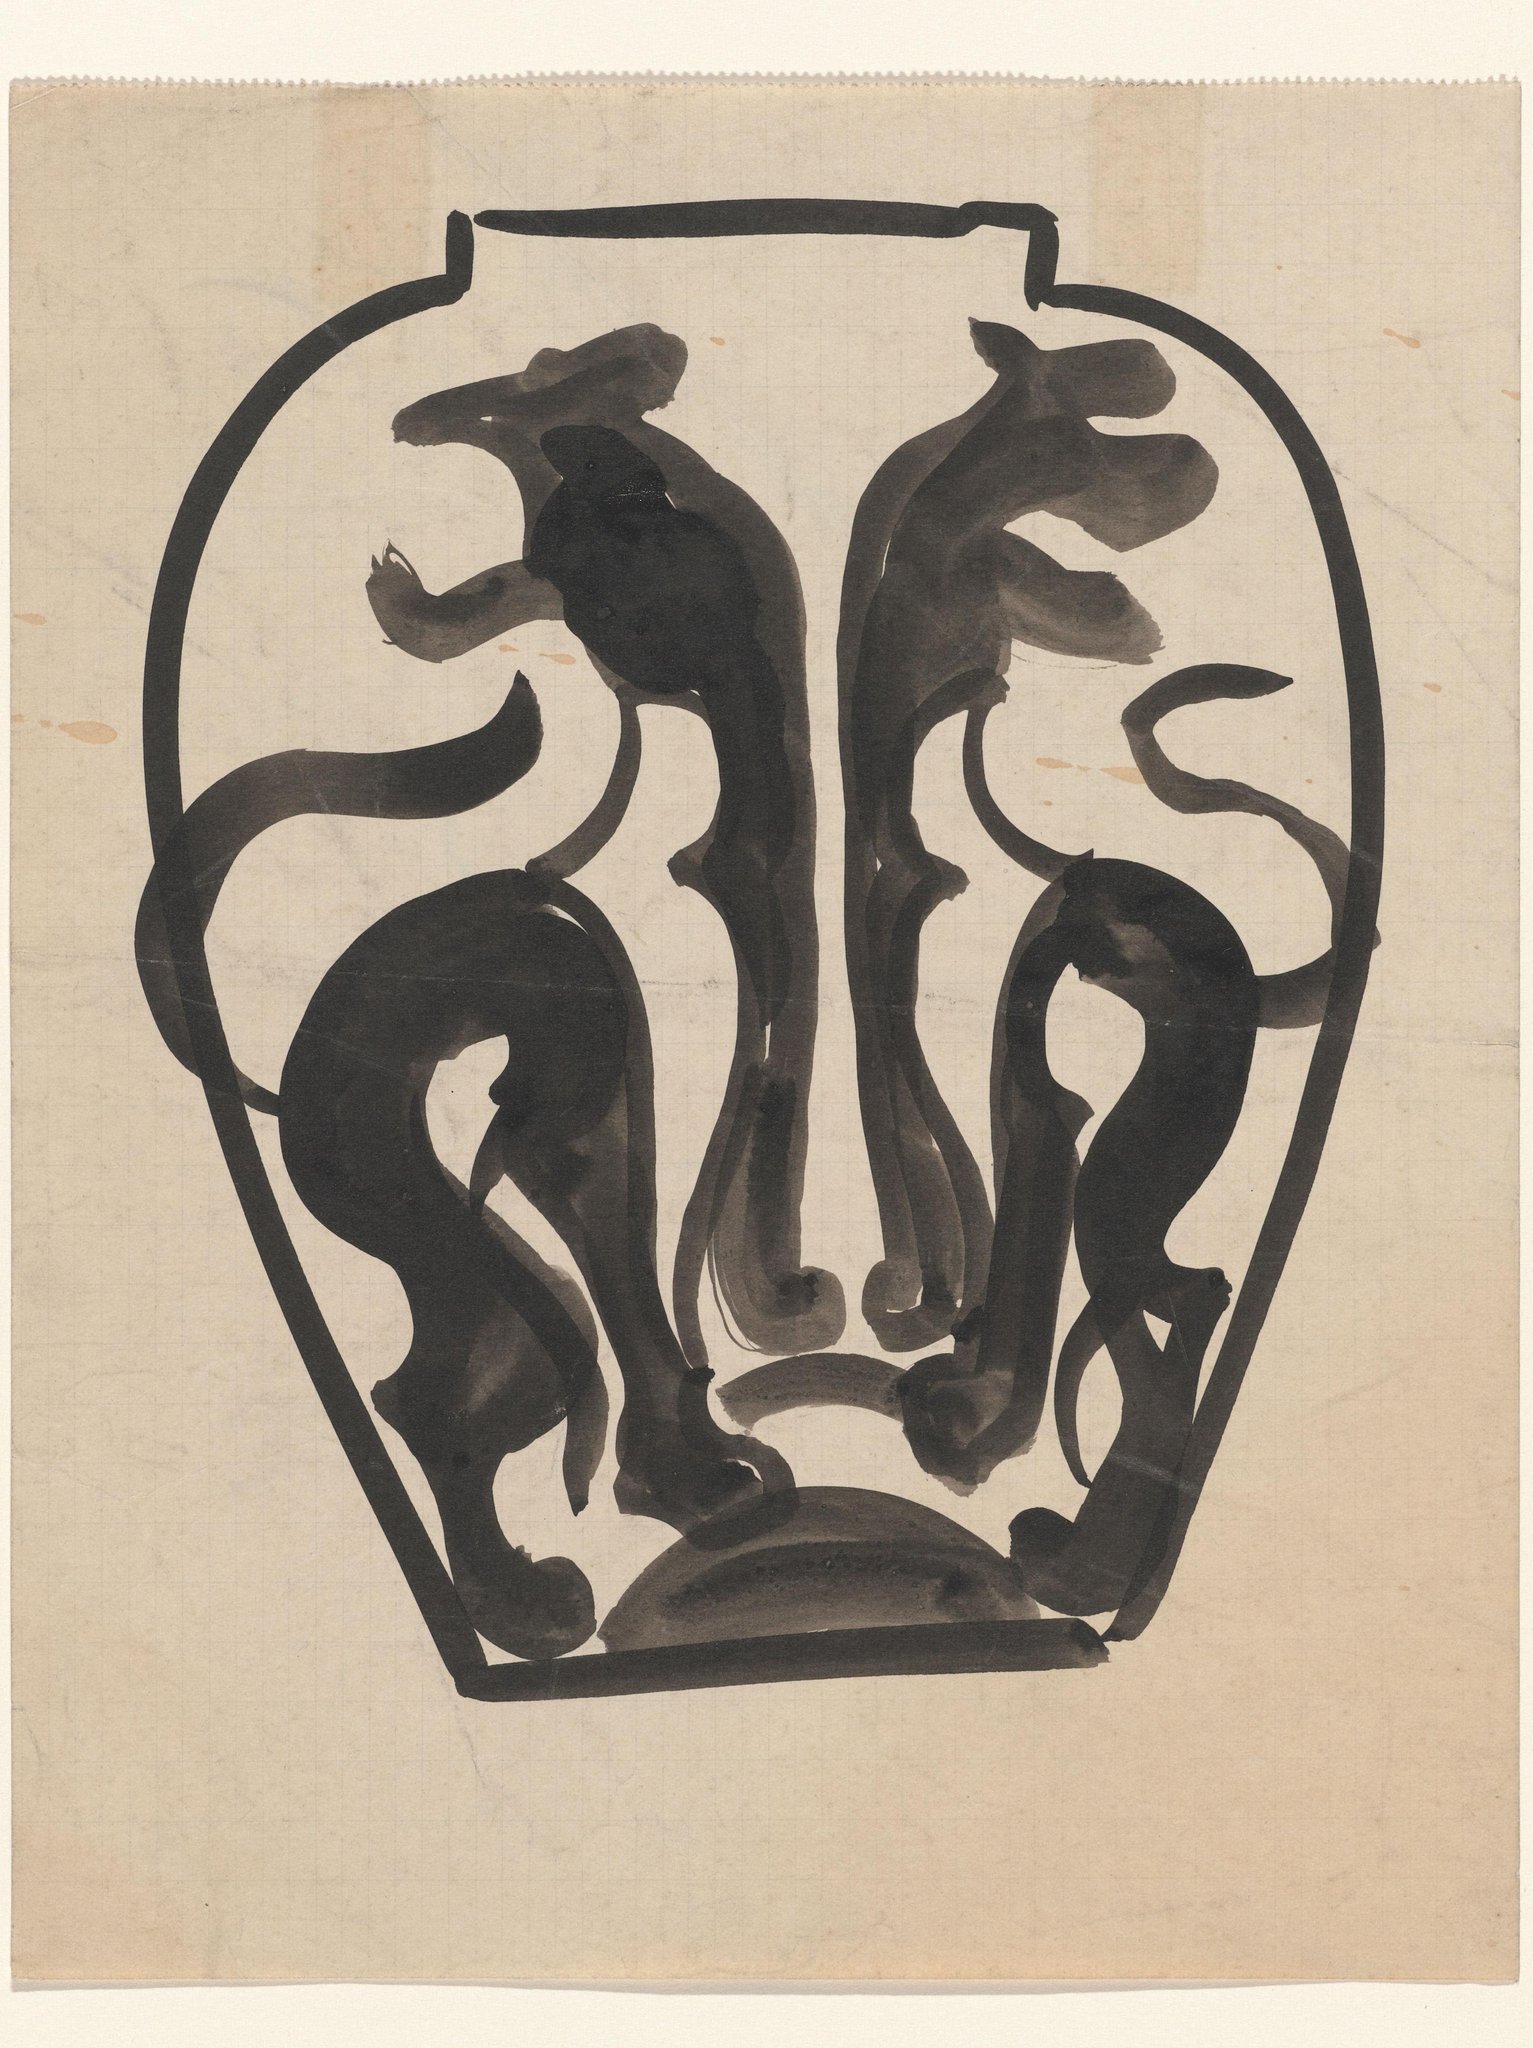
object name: drawing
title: Ontwerp voor een vaas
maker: carel adolph lion cachet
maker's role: draughtsman, print maker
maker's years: 1864-1945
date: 1874-1945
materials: squared paper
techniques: brush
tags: work of applied art (+ ceramics ~ arts), container of ceramics: jar, jug, pot, vase